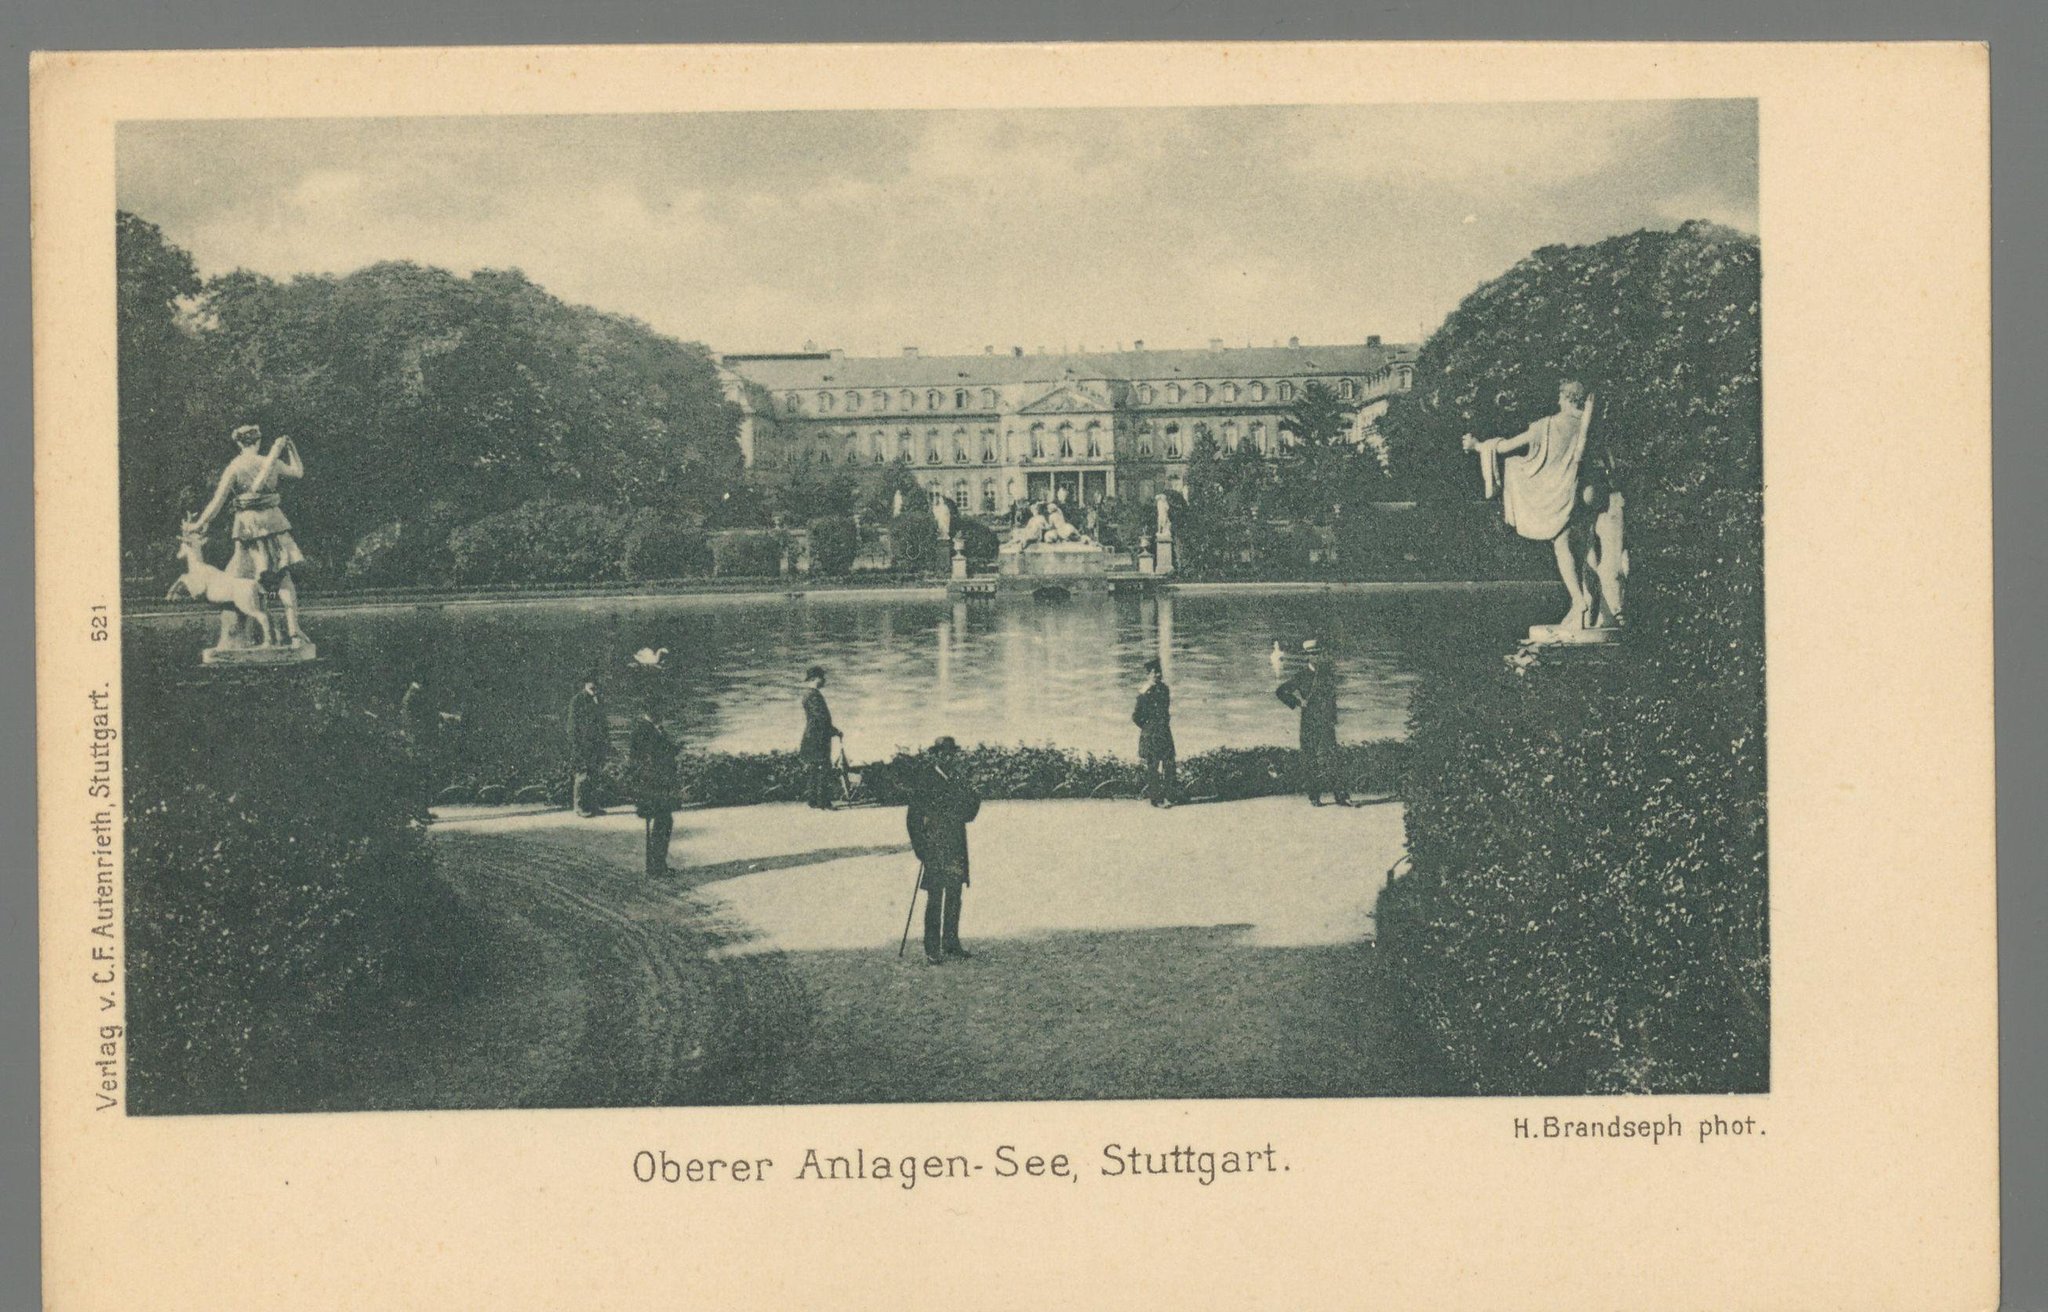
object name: photomechanical print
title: Oberer Anlagen-See, Stuttgart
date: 1885-1905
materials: cardboard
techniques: photograph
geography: stuttgart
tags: castle, lake, monument, statue